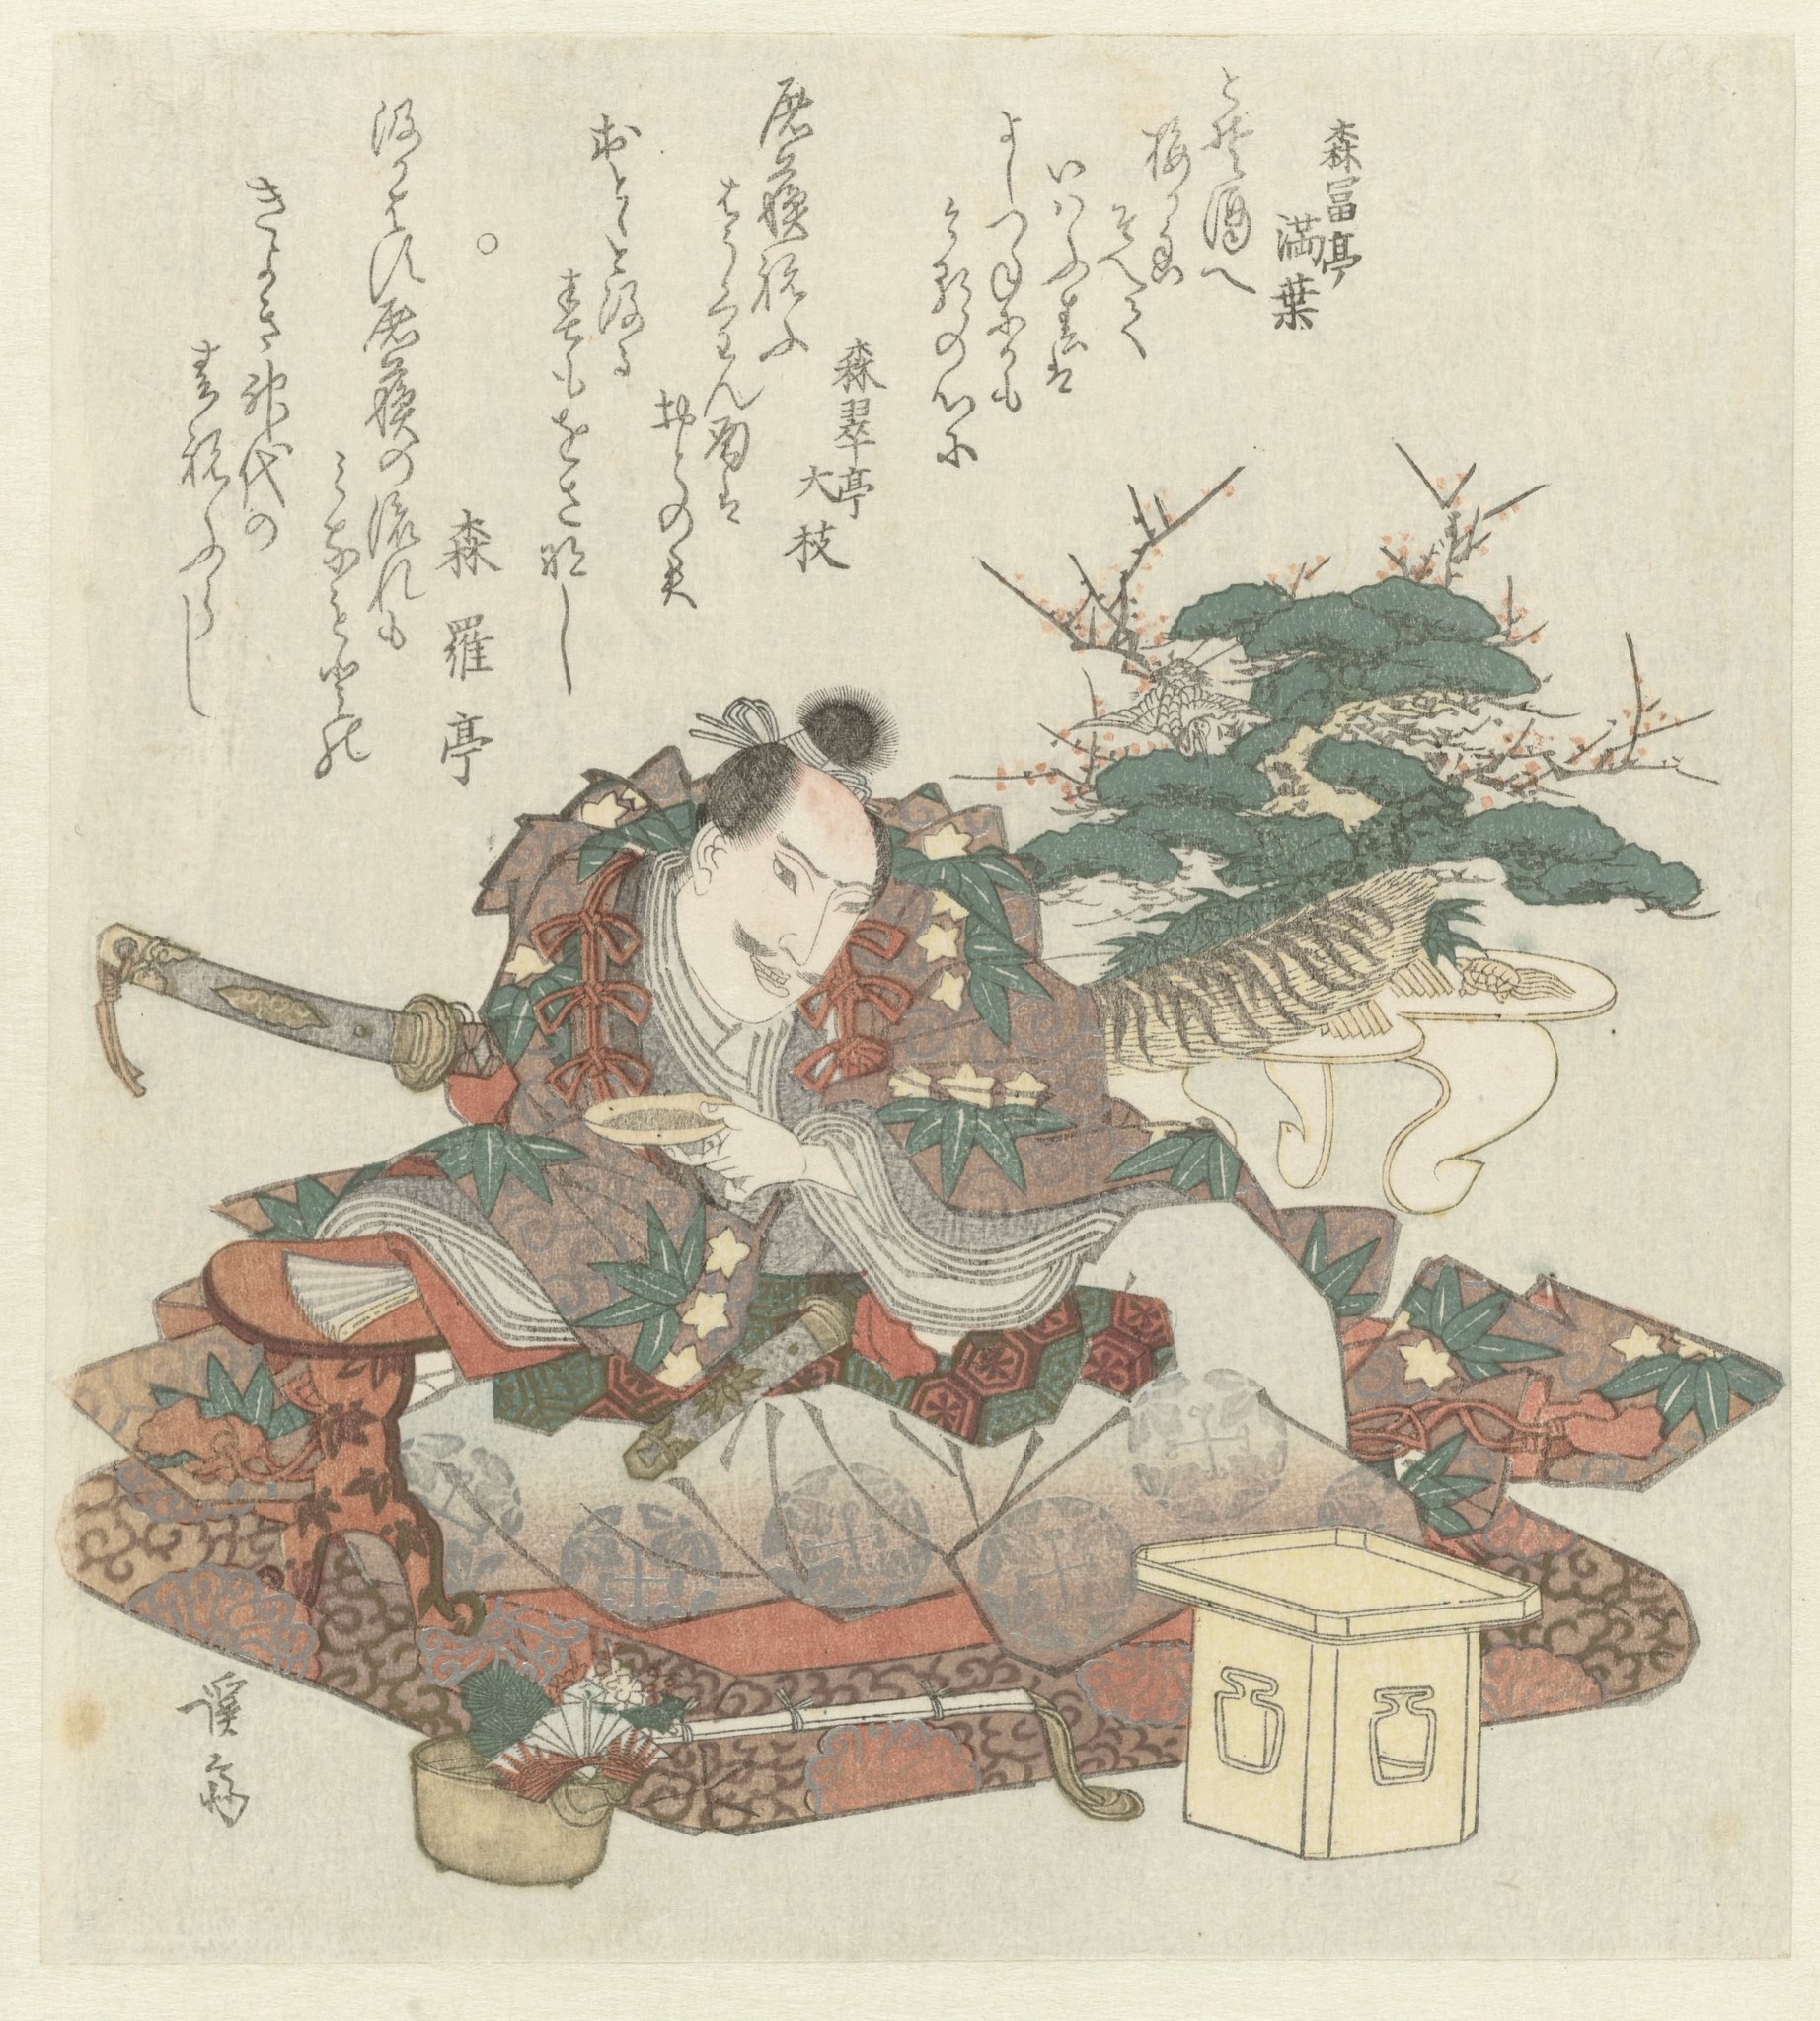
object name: surimono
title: Samoerai met sake-schaaltje in de hand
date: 1825-1830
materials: paper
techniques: woodcut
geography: japan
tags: alcoholic drinks, trees: pine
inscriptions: collector's mark, verso, stamped: Lugt 2228, collector's mark, passe-partout, bottom left, printed: JABdH with a rooster.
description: Een surimono is een luxe uitgevoerde prent waarop beeld met één of meerdere gedichten gecombineerd is. Bij het drukken van een surimono werd vaak gebruik gemaakt van dikker papier, blinddruk en metaal pigmenten, zoals koper- en zilverpoeder. De prenten werden vaak in opdracht van dichters gemaakt en als exclusief geschenk aan vrienden en relaties gegeven.